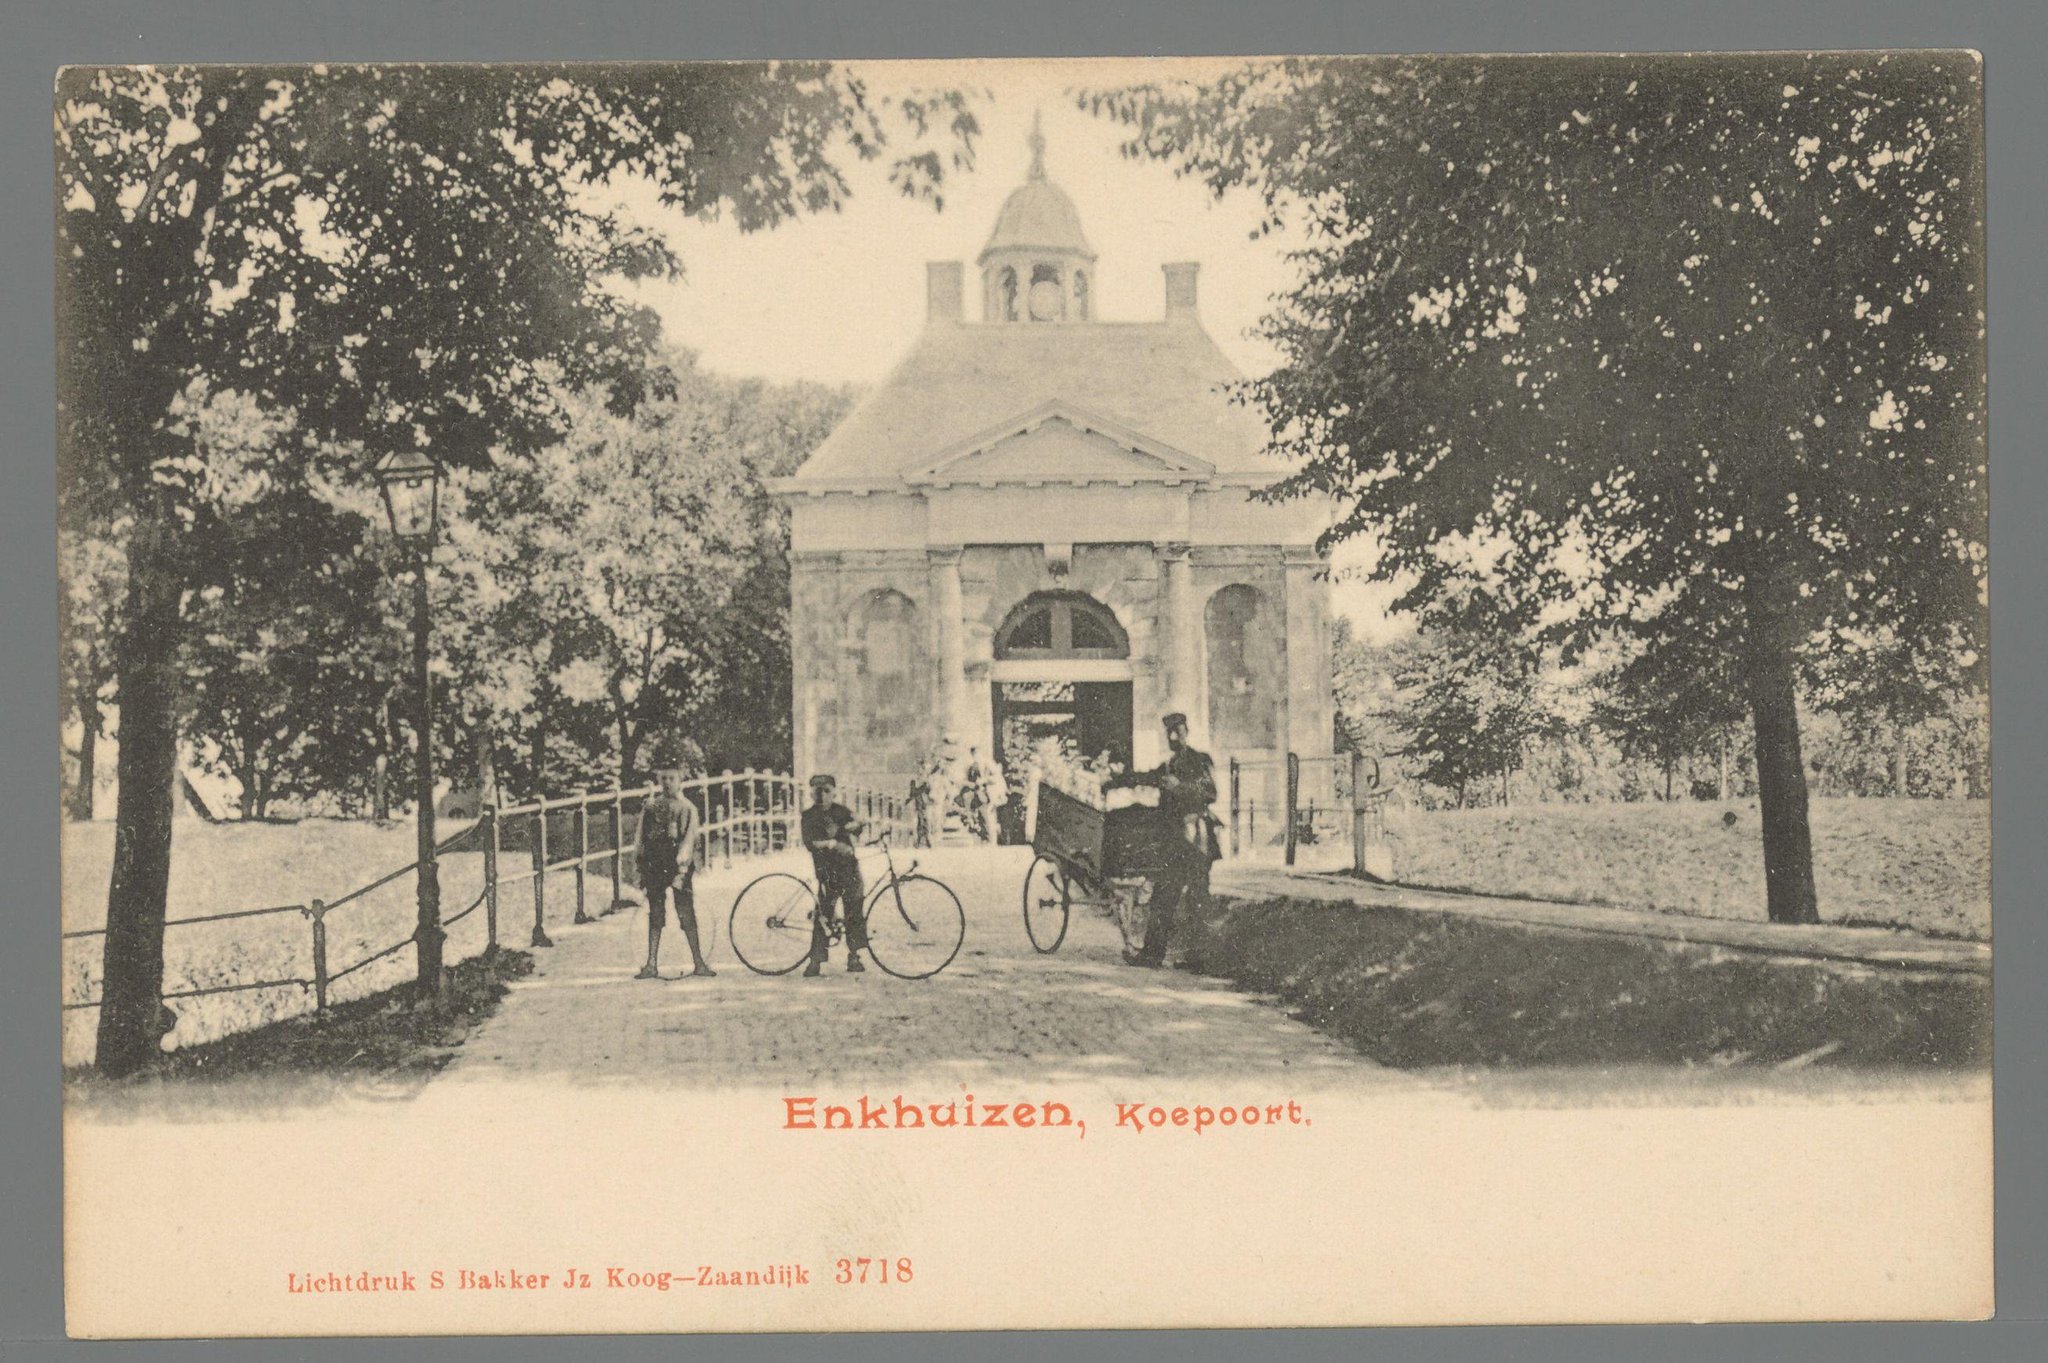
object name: ansichtkaart, prentbriefkaart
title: Enkhuizen, Koepoort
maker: simon bakker jz.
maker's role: printer, publisher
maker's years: 1873-1930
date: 1899-1905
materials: cardboard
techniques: photograph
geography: koog aan de zaan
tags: tower, clock tower ~ monumental adornment, bridge in city across river, canal, etc., city-gate, enkhuizen